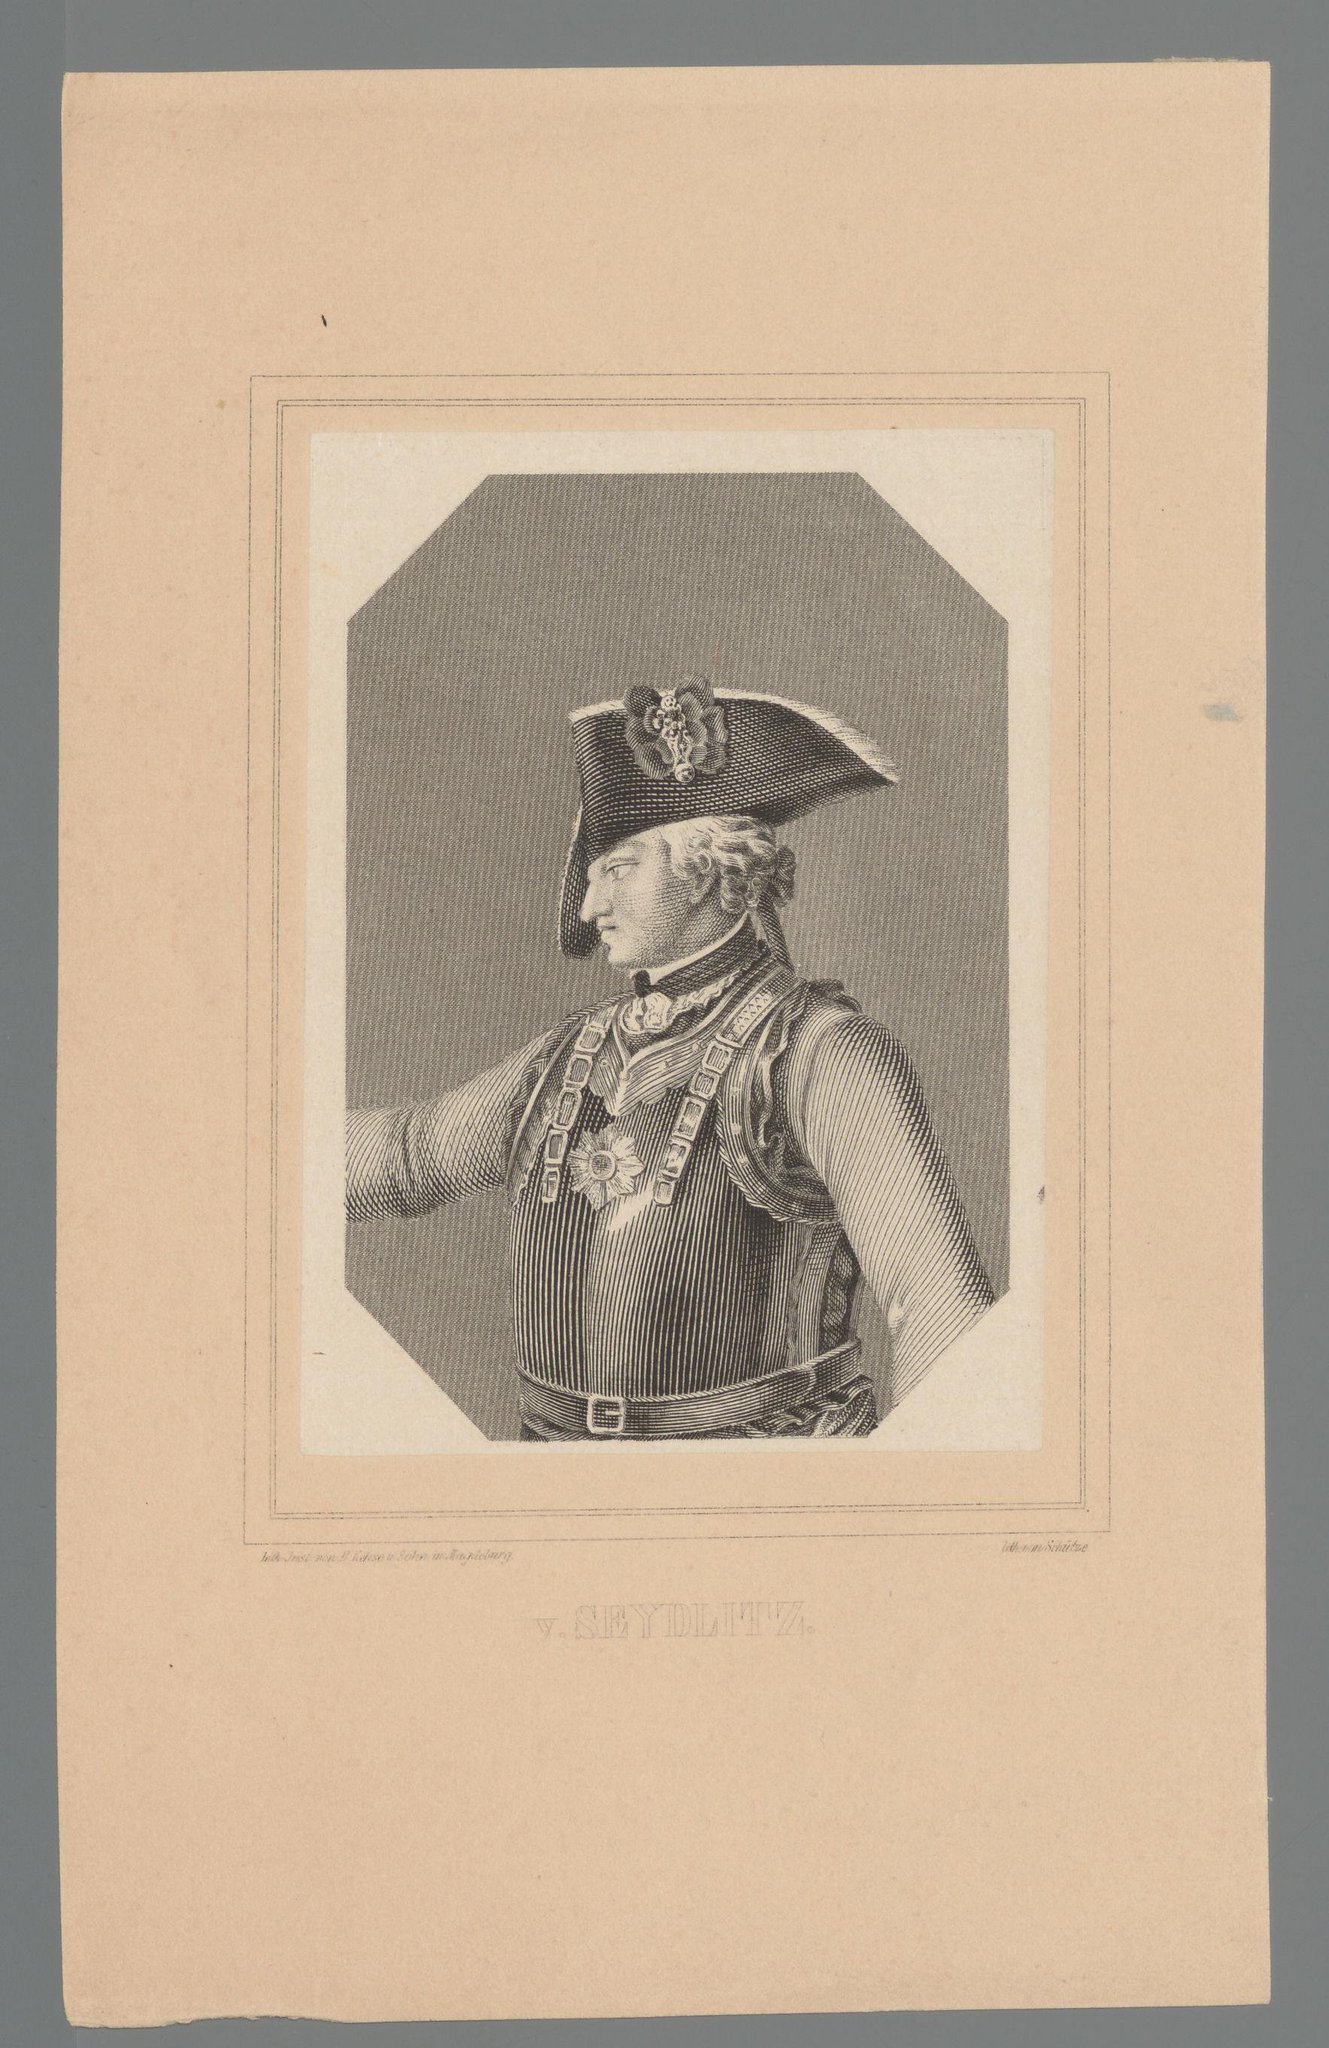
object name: print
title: Portret van Friedrich Wilhelm baron von Seydlitz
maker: h. schuetze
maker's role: print maker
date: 1830-1840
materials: paper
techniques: lithograph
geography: magdeburg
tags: kalkar, commander-in-chief, general, marshal, historical persons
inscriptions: collector's mark: Lugt 2228